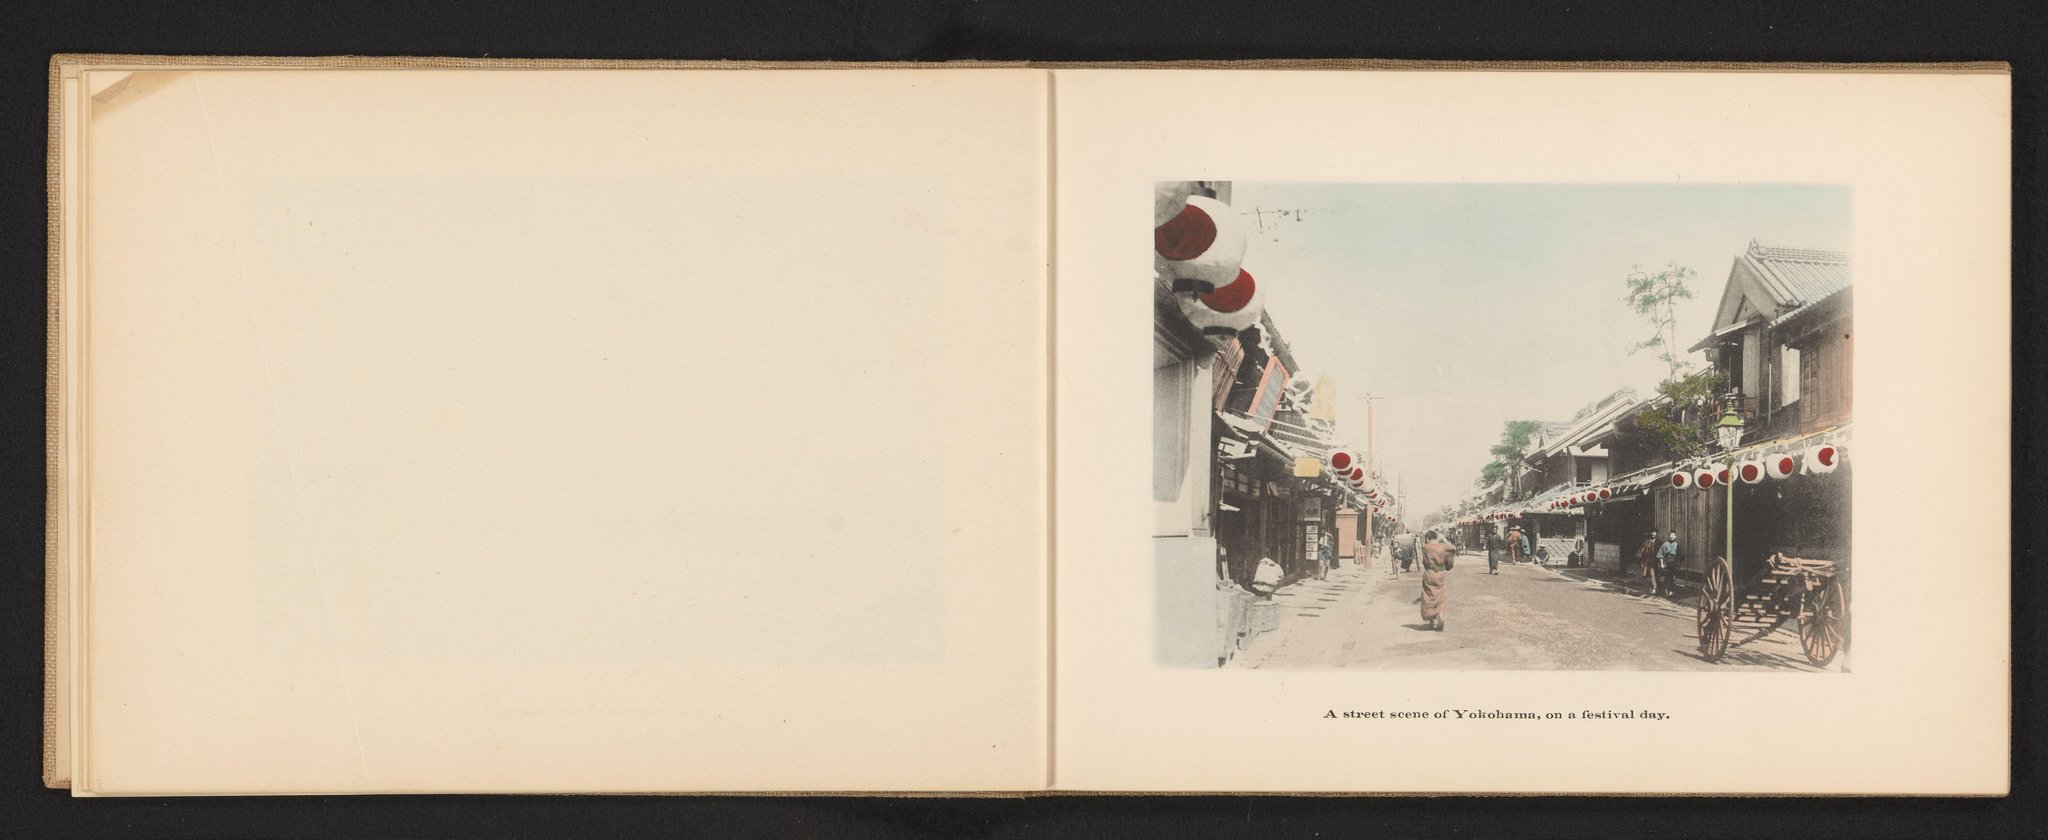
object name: photomechanical print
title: A street scene of Yokohama, on a festival day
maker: kōzaburō tamamura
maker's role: fotograaf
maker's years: 1856-1923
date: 1895-1905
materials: paper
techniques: photograph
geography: yokohama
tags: hand-cart, village street, street lighting